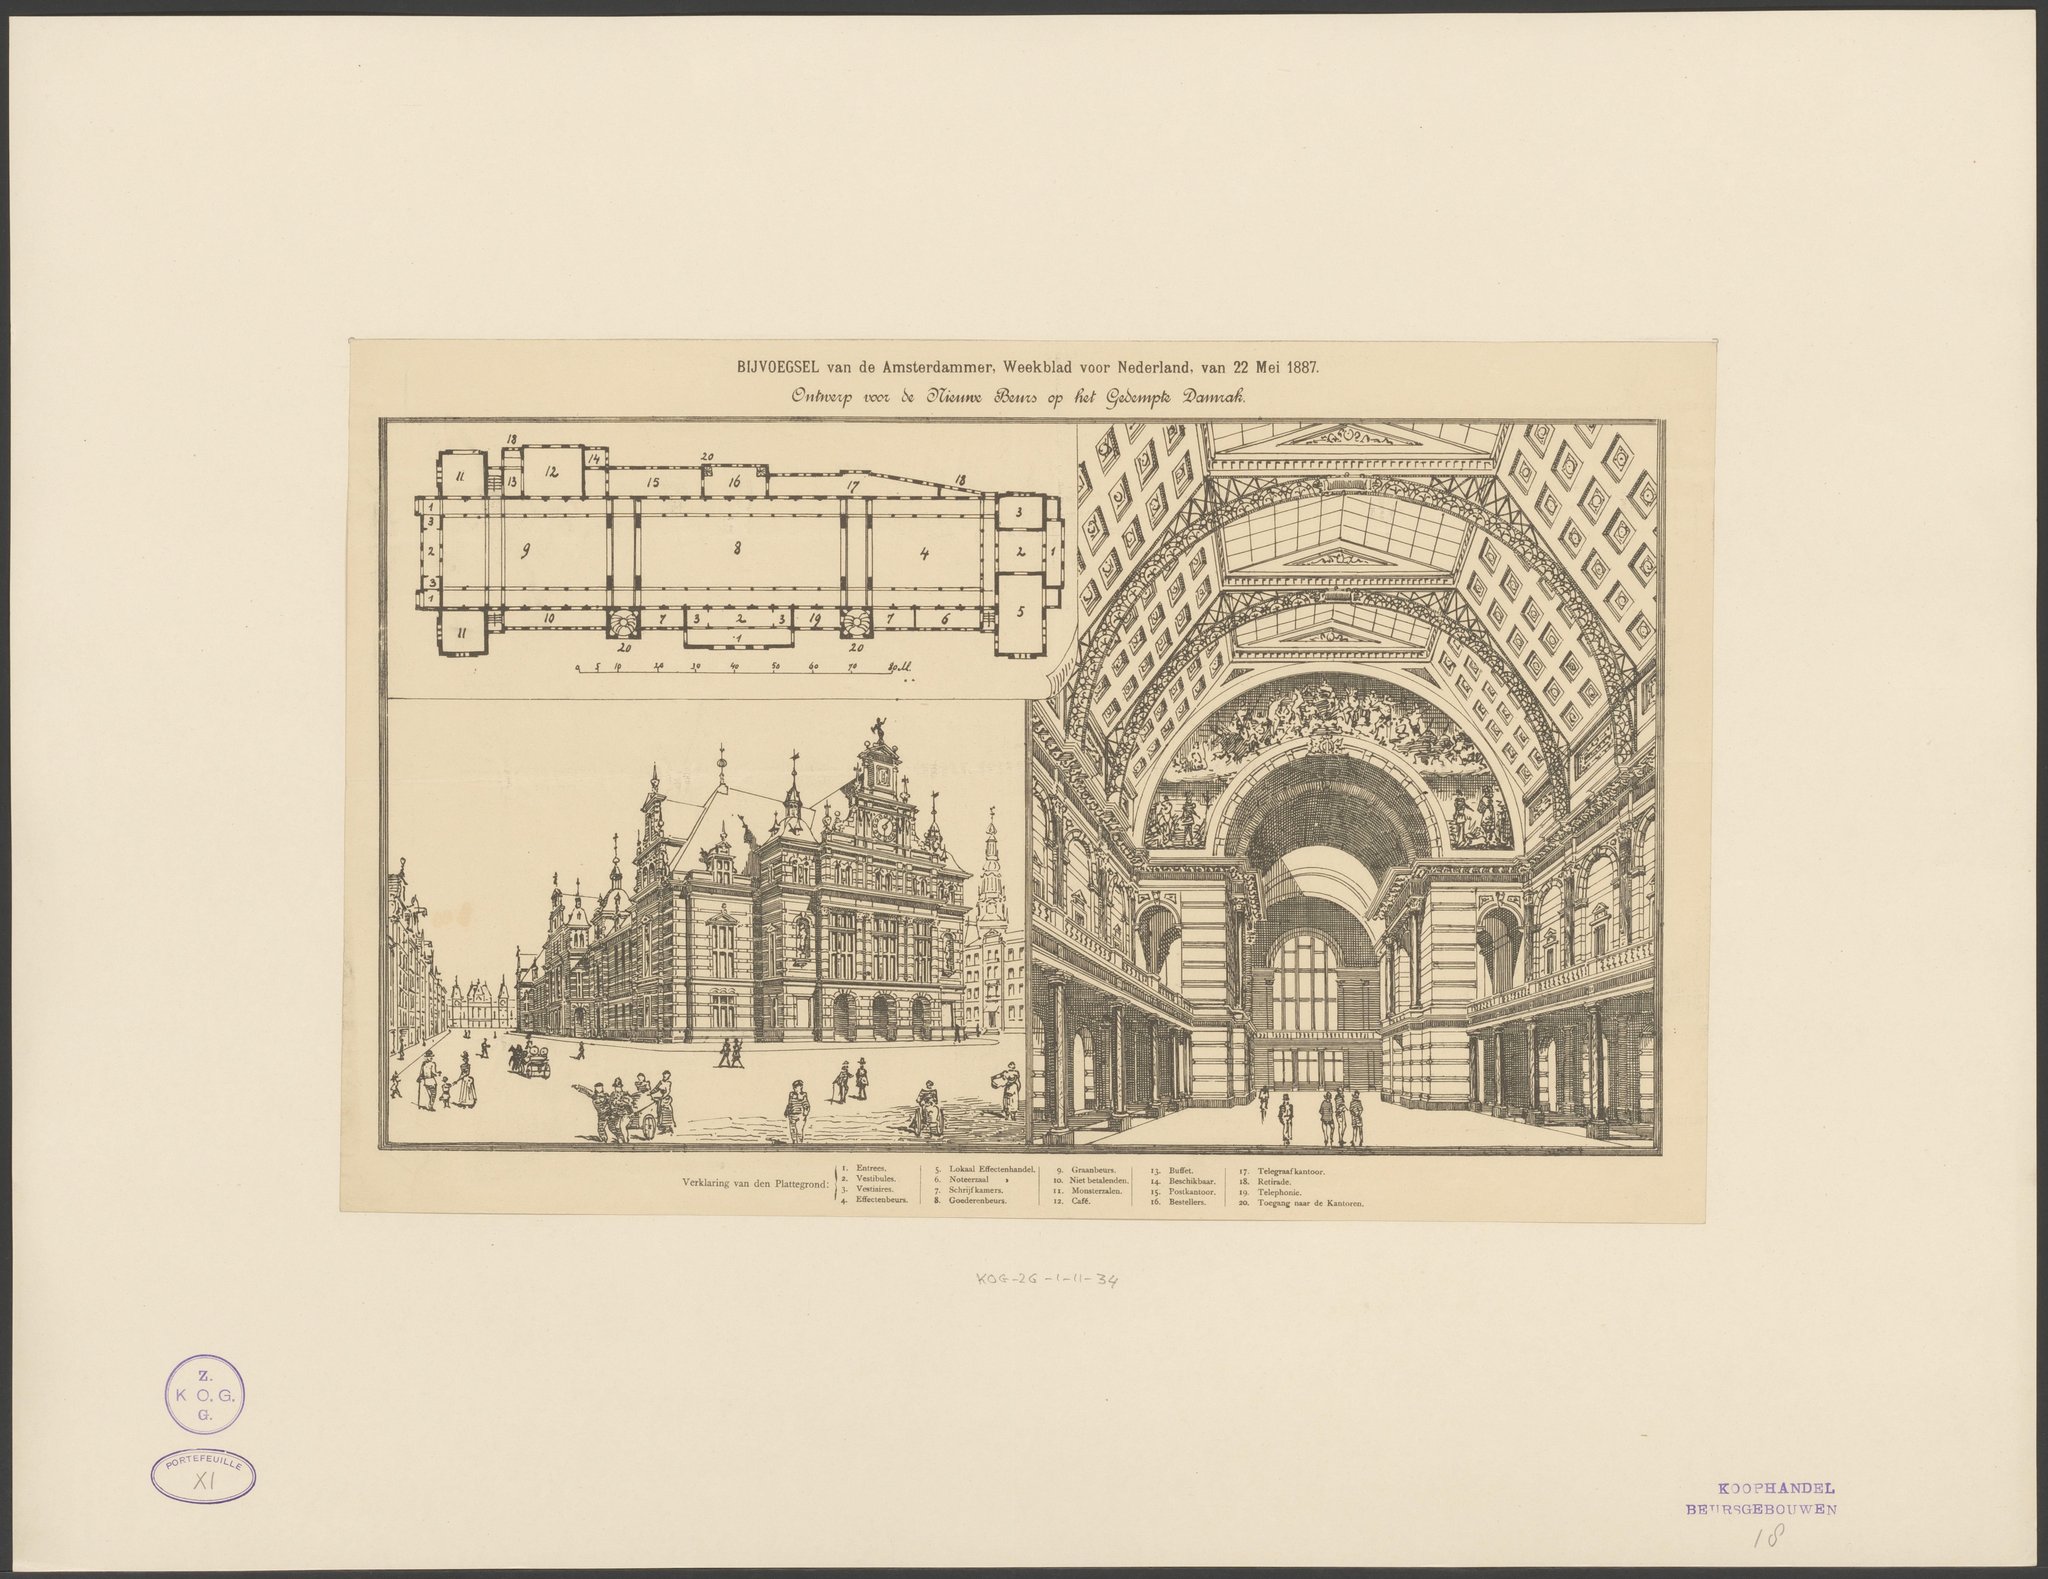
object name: print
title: Ontwerp voor de Nieuwe Beurs op het Gedempte Damrak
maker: Anonymous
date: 1887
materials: paper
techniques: lithograph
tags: stock exchange, stock-market, amsterdam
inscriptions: stamp, collector's mark: Lugt 1641, stamp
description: Gezicht op het interieur en exterieur van de de Beurs van Berlage. Linksboven de bouwplattegrond van de beurs. Onderaan de legenda. Onderwerpsrubrieken binnen de Atlas Zeden en Gewoonten: Handel, nijverheid en verkeer, Koophandel, Beursgebouwen.